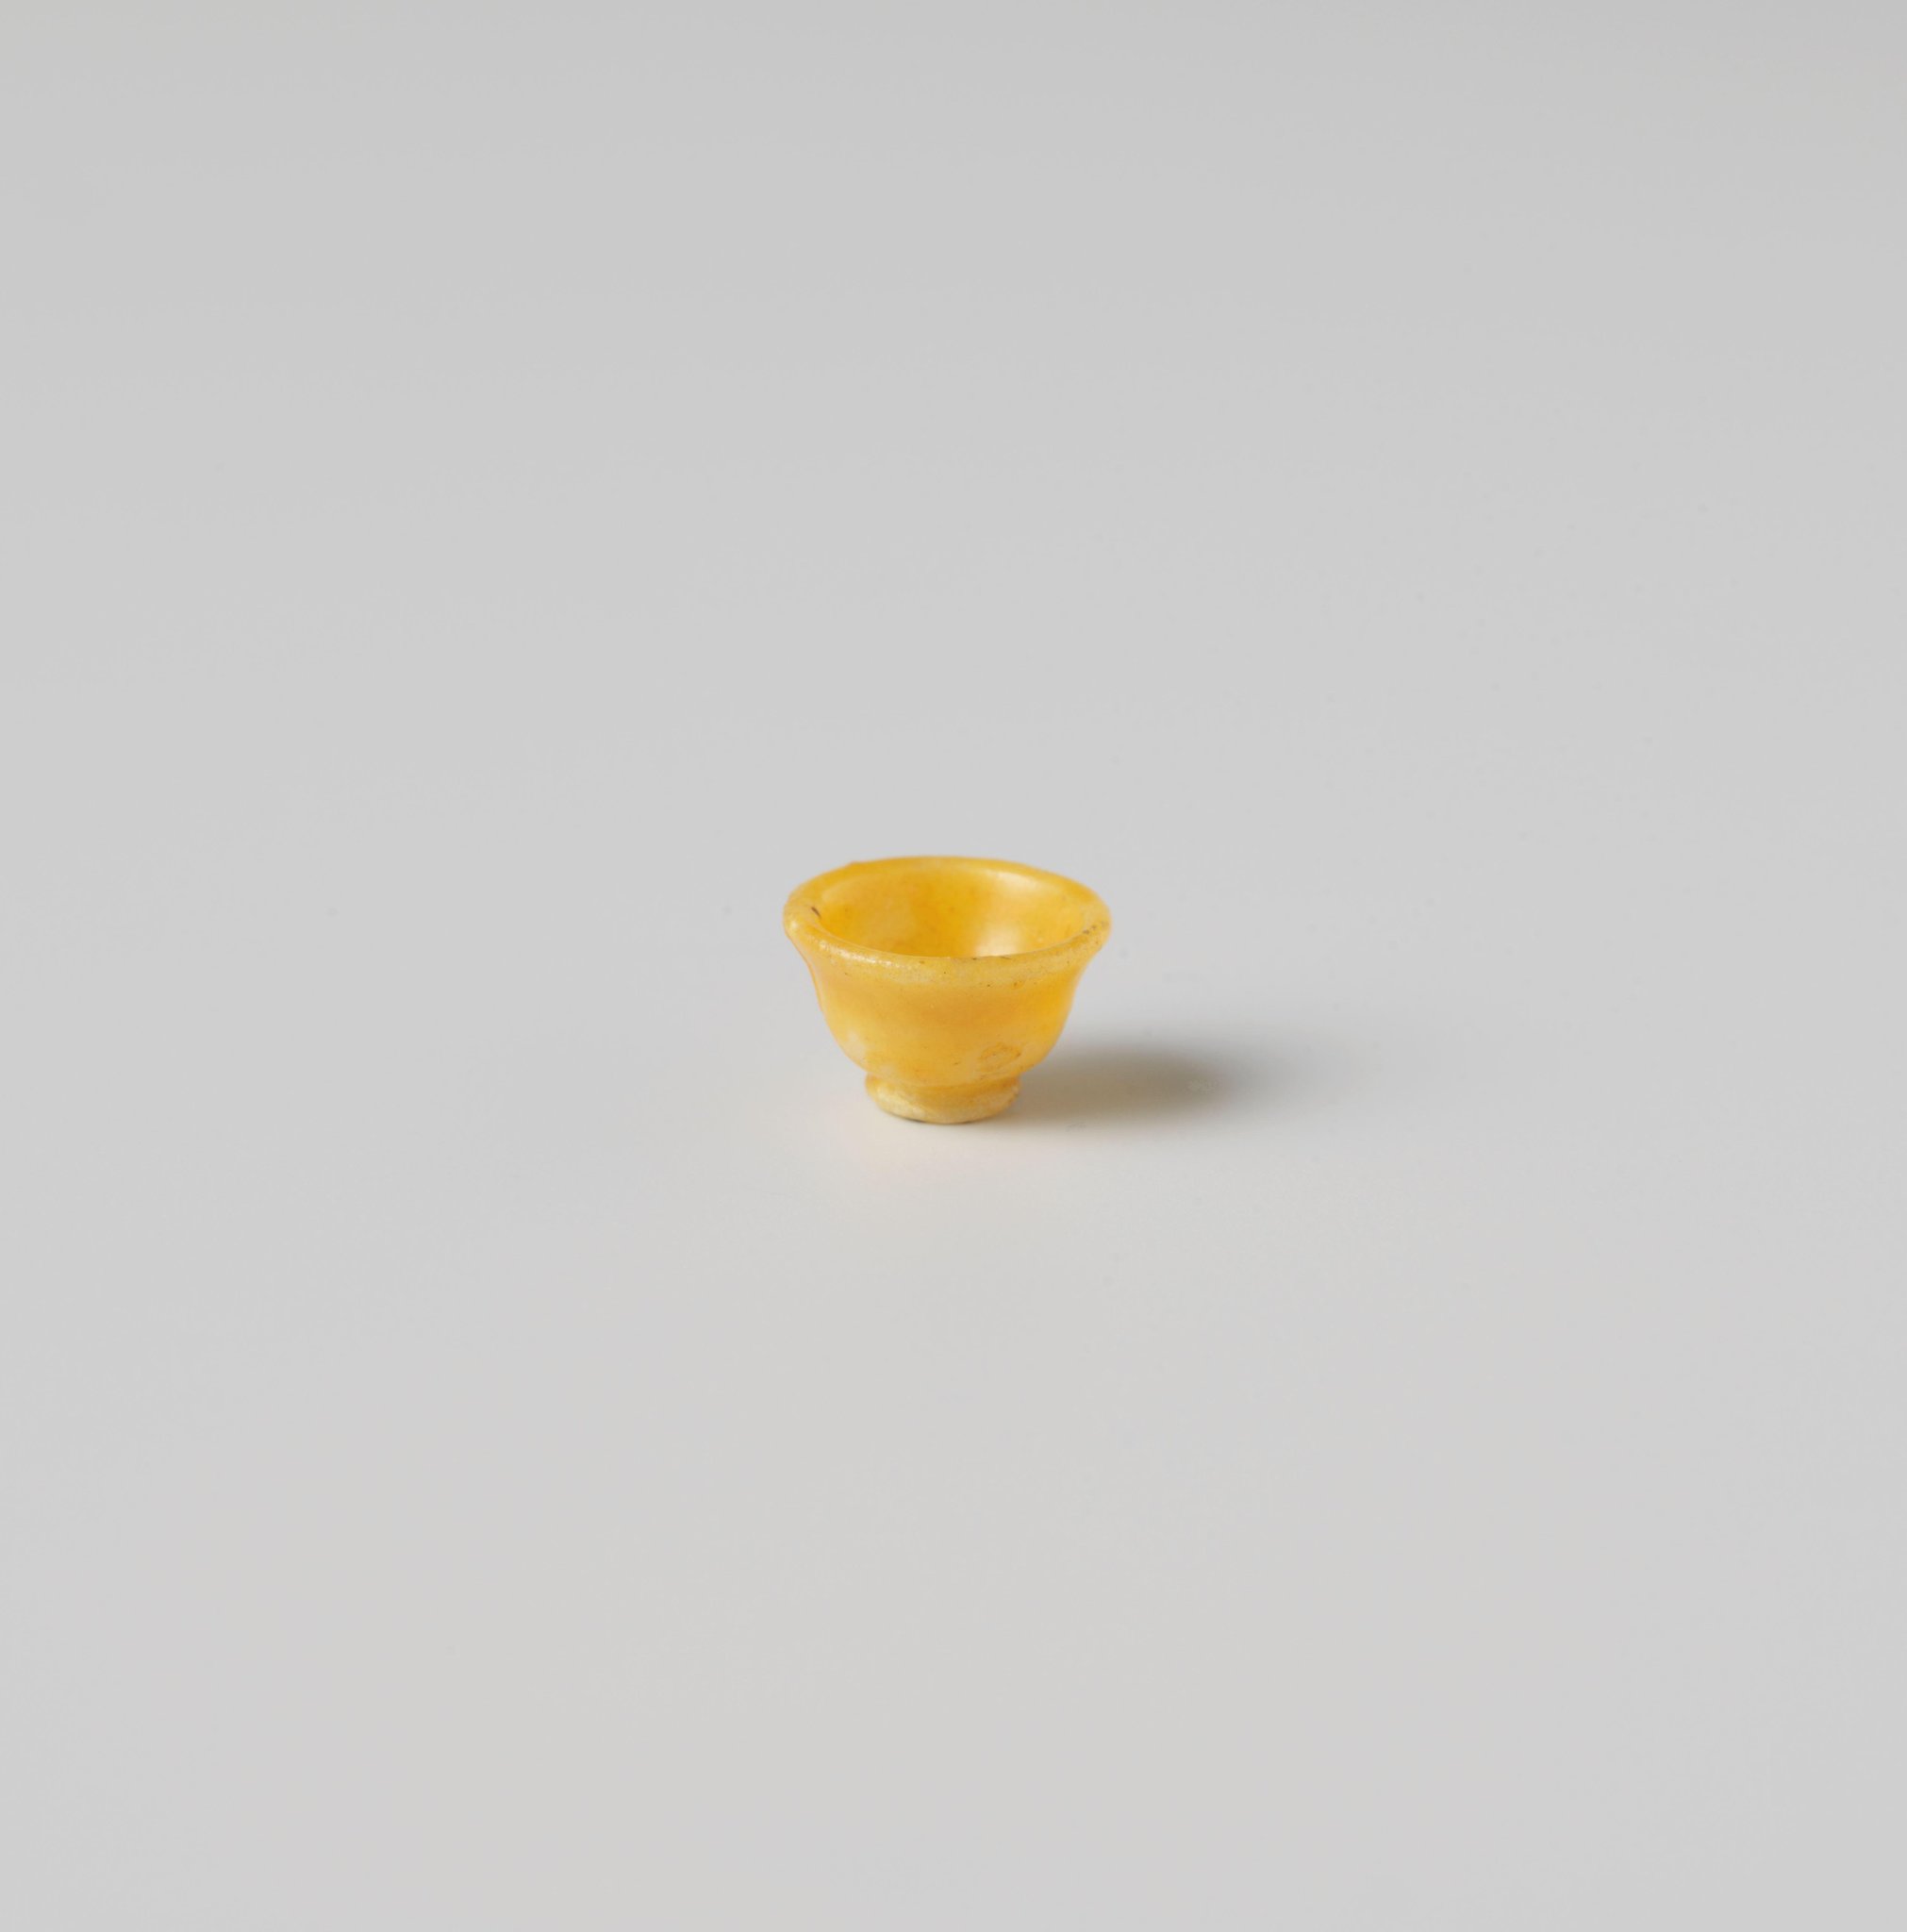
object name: bowl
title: Kom, geelgelakt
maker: Anonymous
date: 1750-1800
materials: alabaster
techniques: lacquer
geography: germany